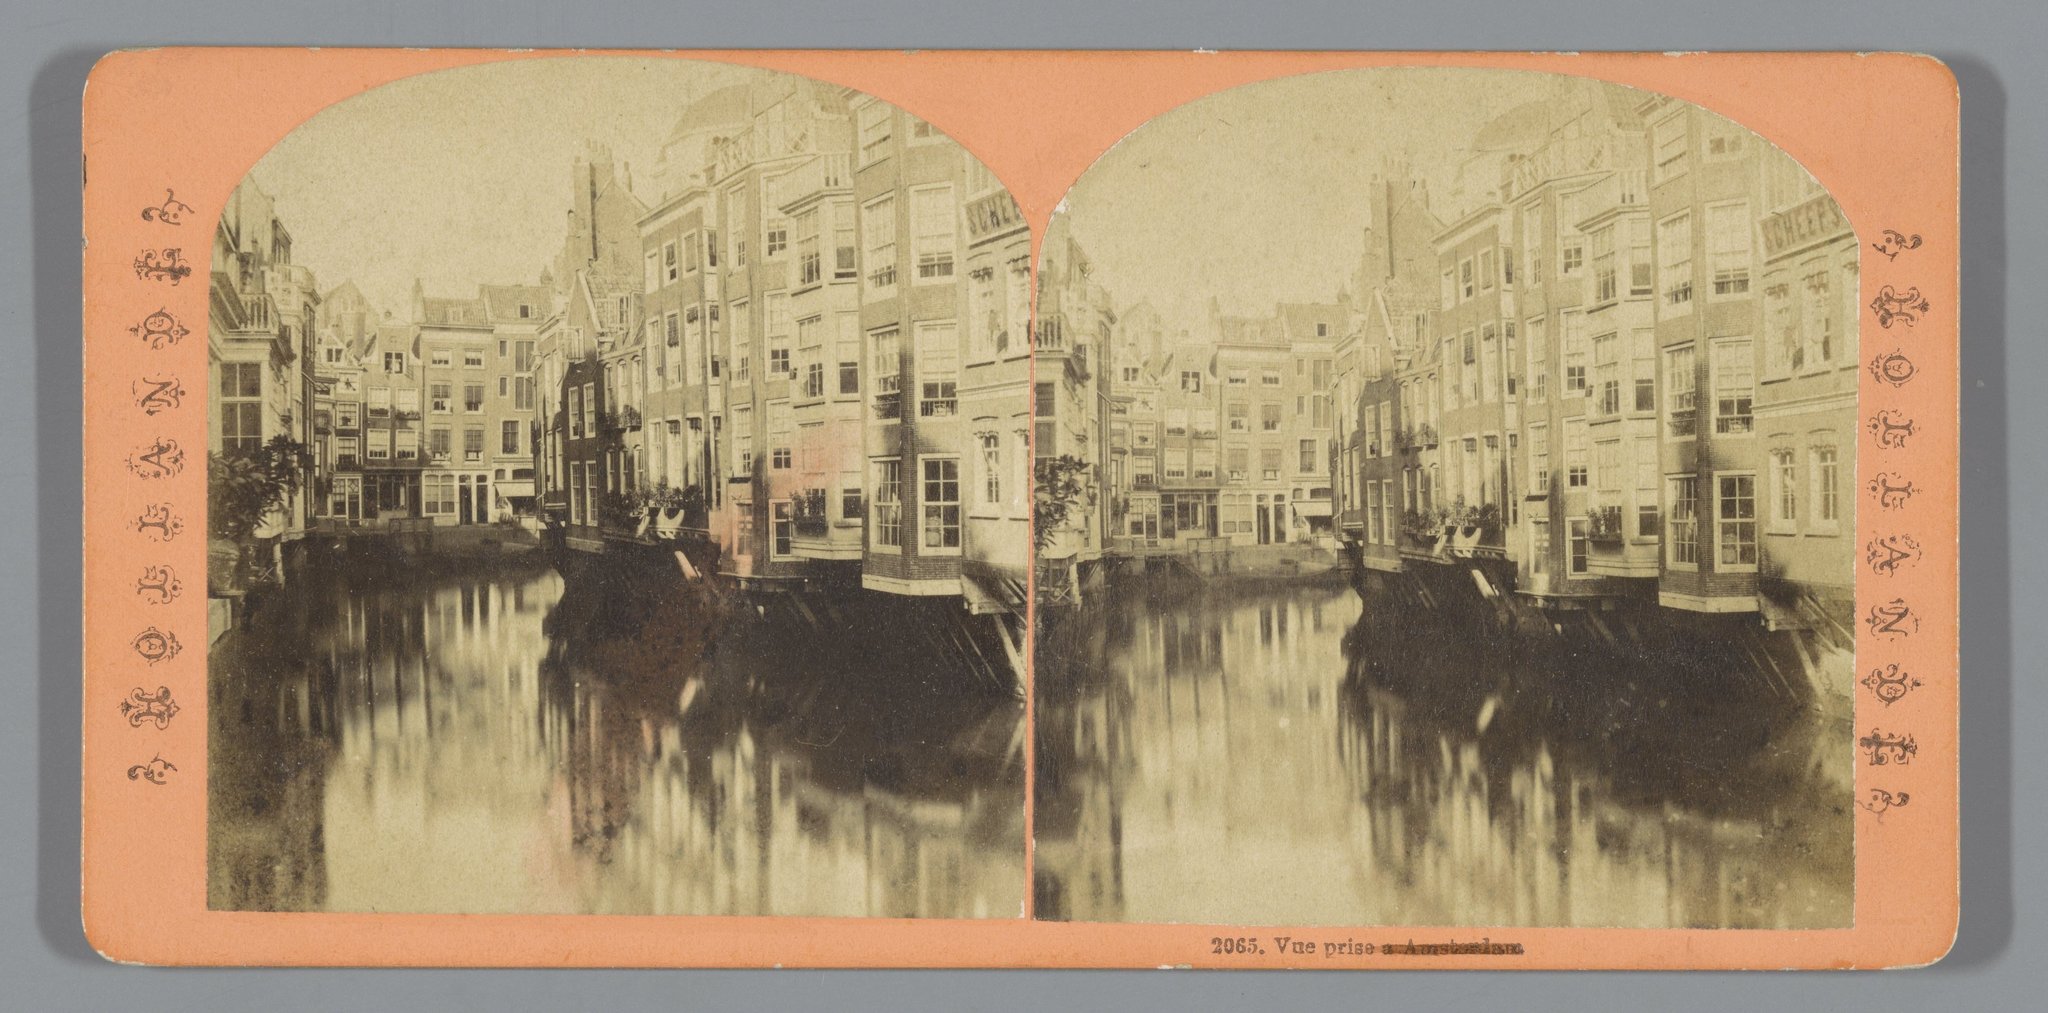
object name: stereograph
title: Vue prise a Amsterdam [?]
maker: Anonymous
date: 1866-1870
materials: cardboard, paper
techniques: albumen print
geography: amsterdam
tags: canals, waters (in city), netherlands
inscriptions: number: ‘2065’, number: ‘40’